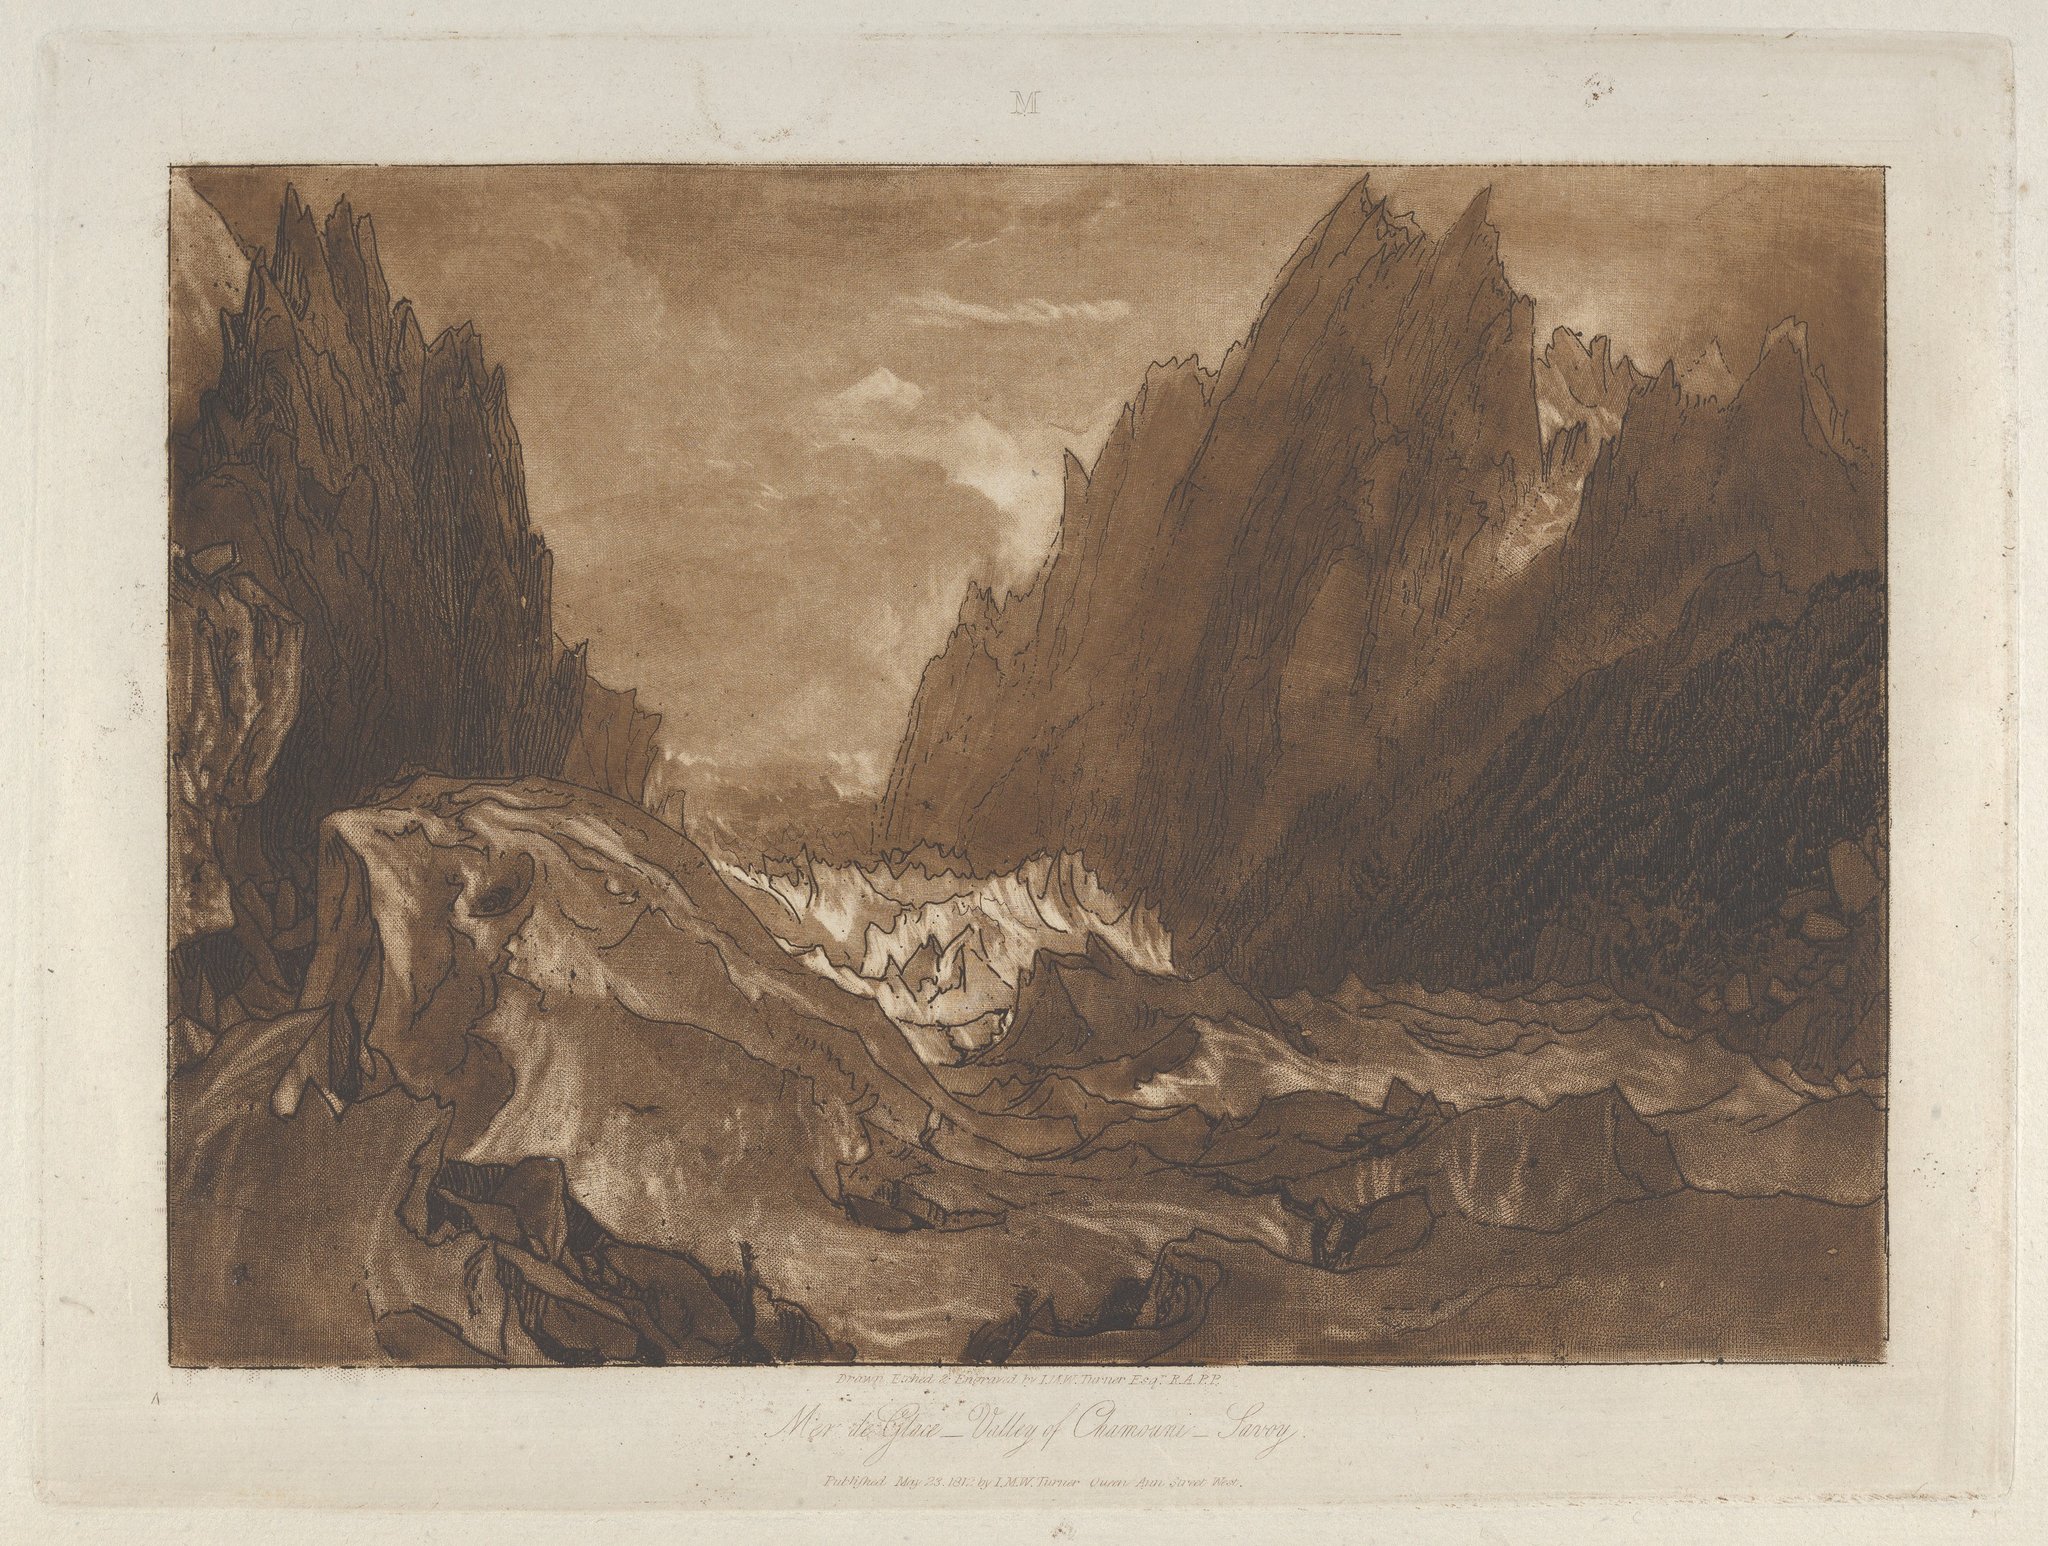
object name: print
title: Mêr de Glace, Valley of Chamouni-Savoy (Liber Studiorum, part X, plate 50)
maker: joseph mallord william turner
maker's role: artist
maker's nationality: british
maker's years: 1775-1851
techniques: etching, mezzotint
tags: mountains,landscapes